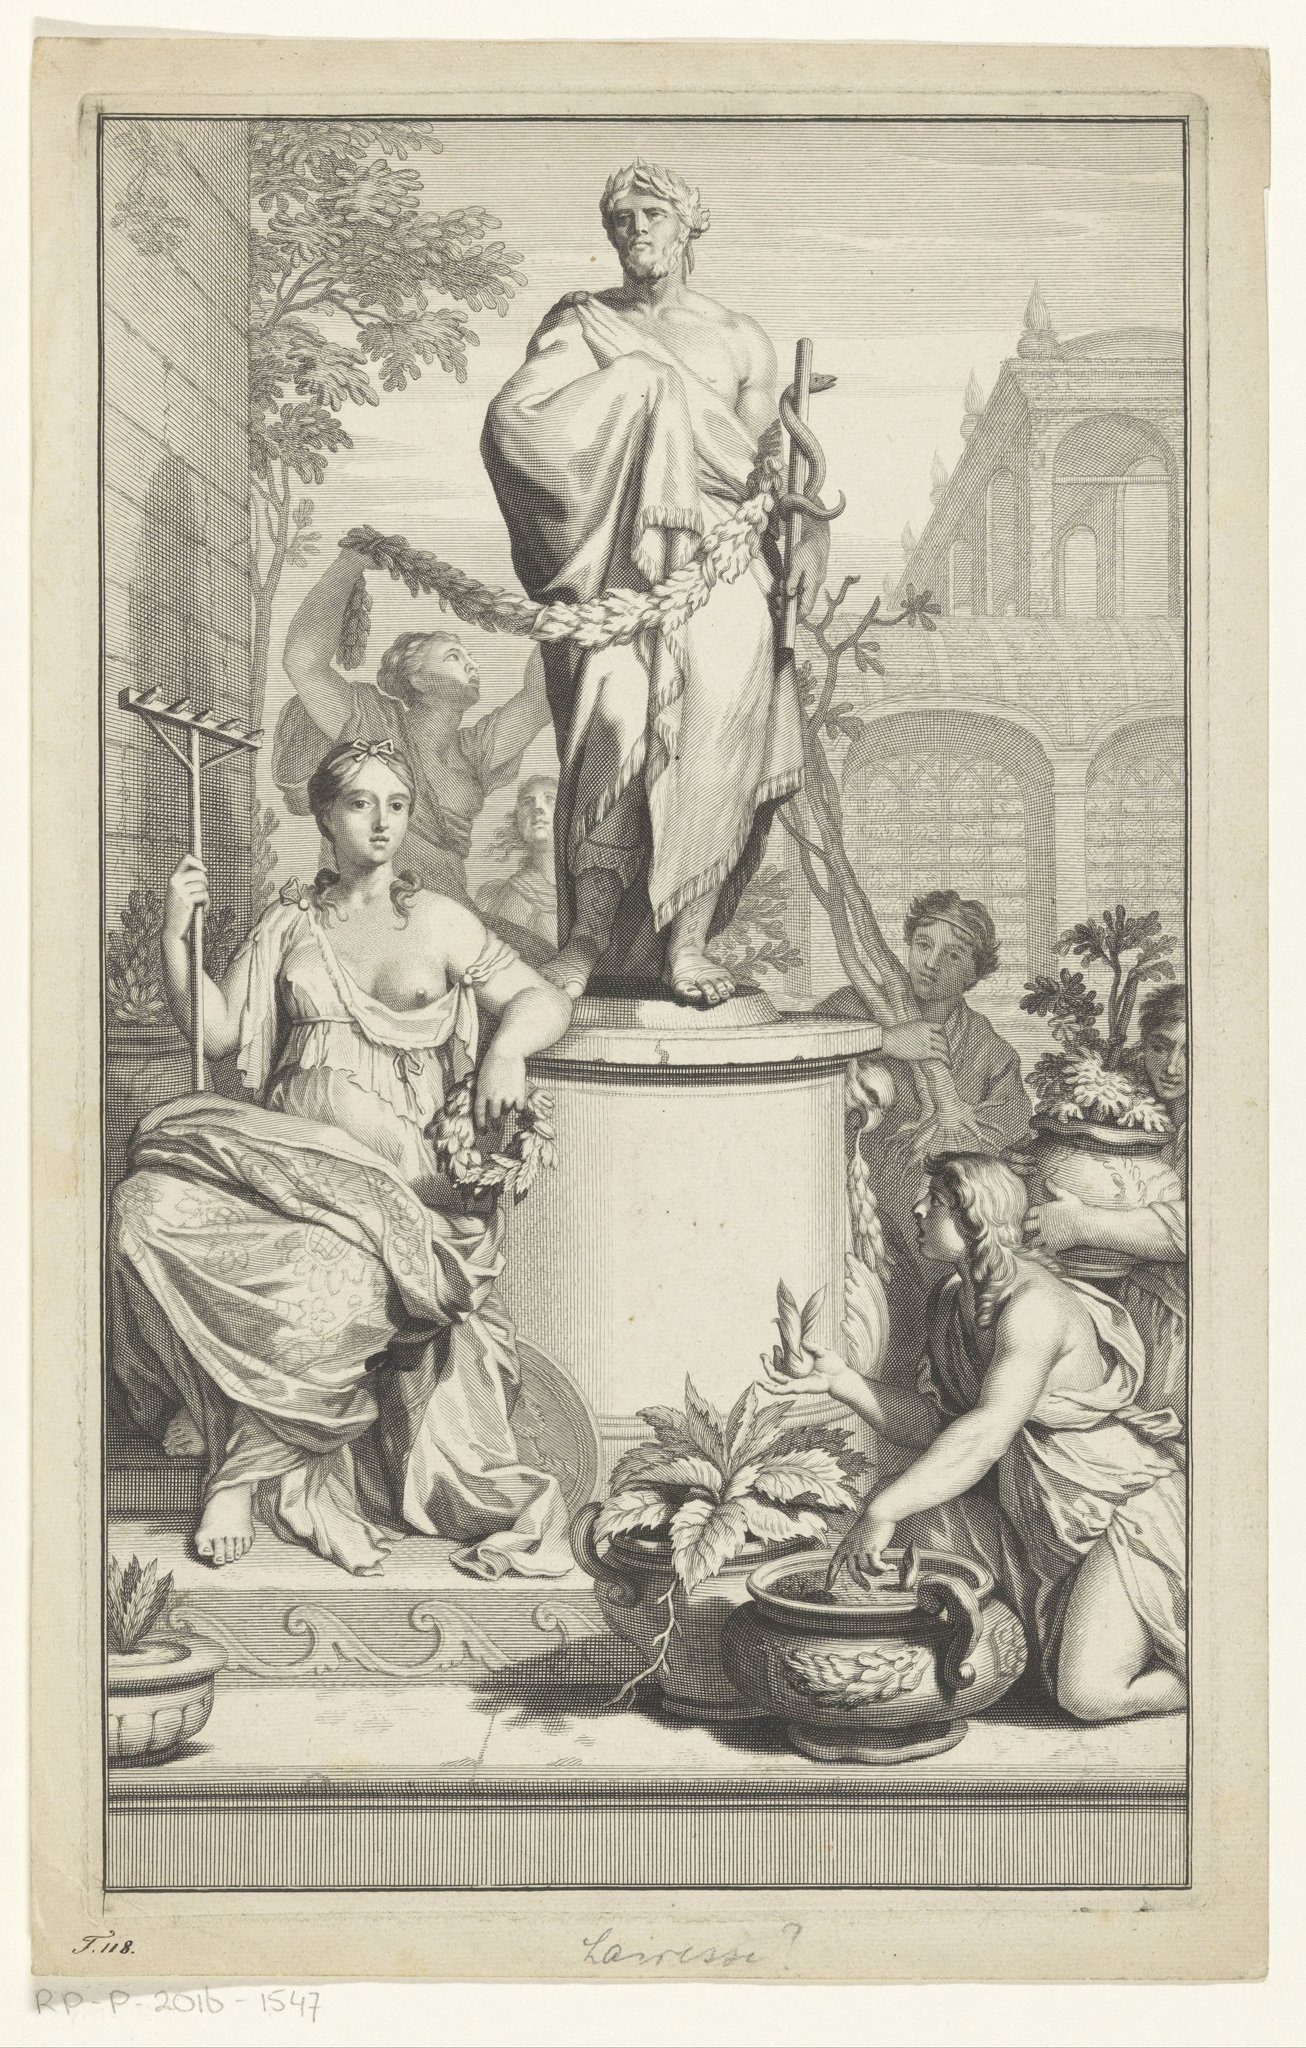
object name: print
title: Asclepius omringd door allegorische vrouwenfiguur en figuren met boom en planten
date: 1696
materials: paper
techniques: engraving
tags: plants (in general), gardening, (story of) aesculapius (asclepius), agricultural implements: rake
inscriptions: collector's mark: Lugt 11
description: Asclepius staat met esculaap op een voetstuk. Naast hem zit een allegorische vrouwenfiguur met een hark en een krans in haar handen. Rechts staan twee mannen met een boom en een plant in een pot. Een zittende figuur rechts plant kiemen in een pot.